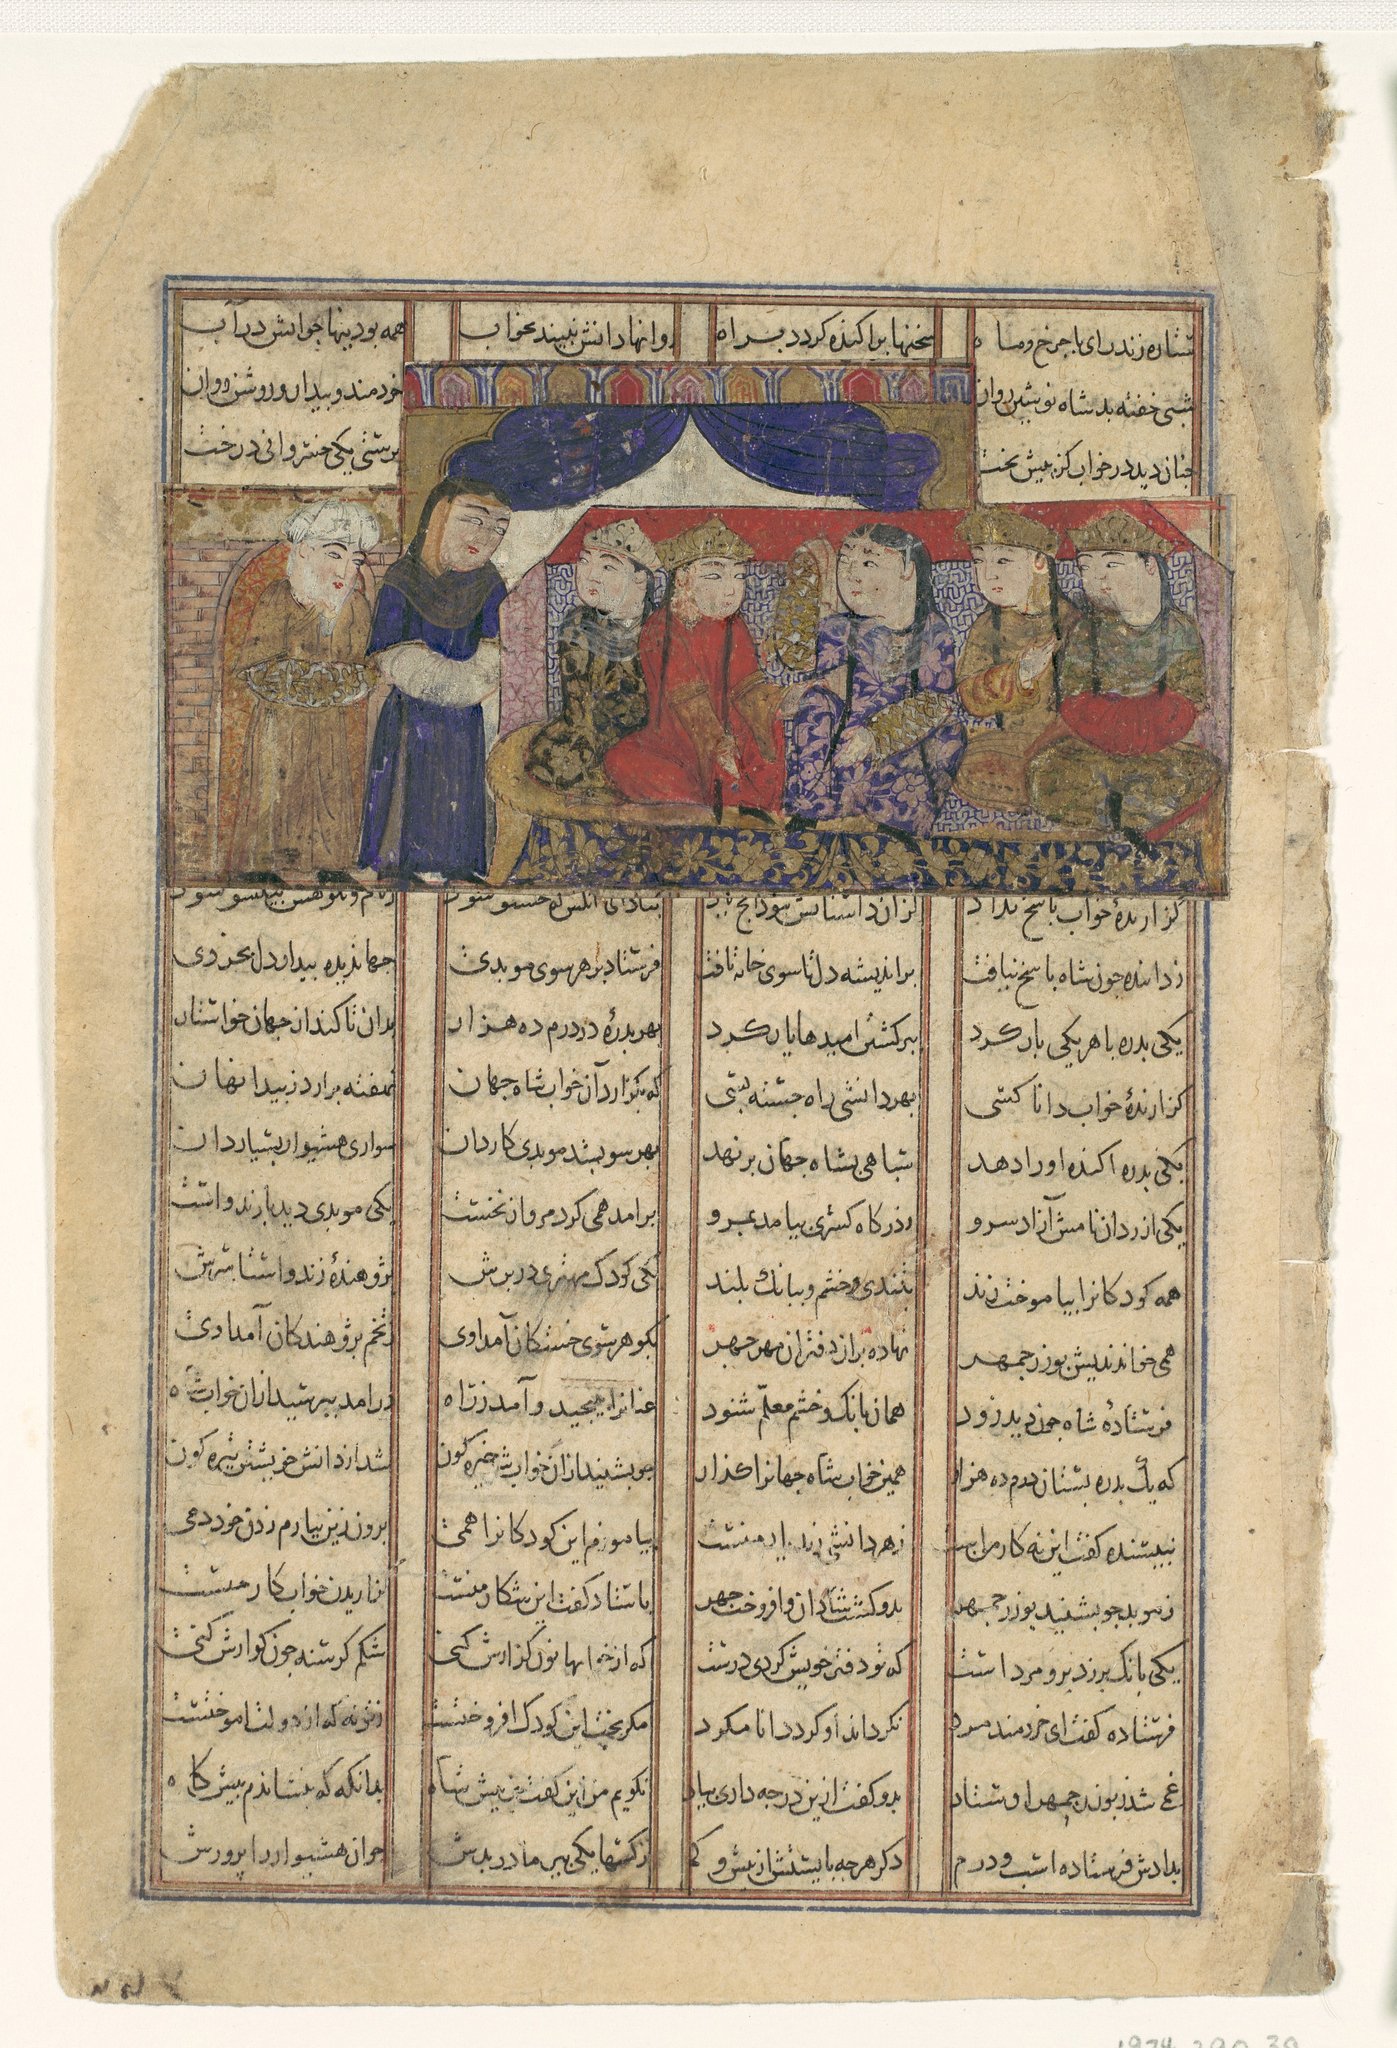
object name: folio from an illustrated manuscript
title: "Mihran Sitad Chooses a Daughter of the Khaqan of Chin", Folio from a Shahnama (Book of Kings) of Firdausi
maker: abu'l qasim firdausi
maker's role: author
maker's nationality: iranian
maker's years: 935-1020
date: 1330-1340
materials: gold, ink, paper, silver, watercolor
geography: iran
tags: men,women